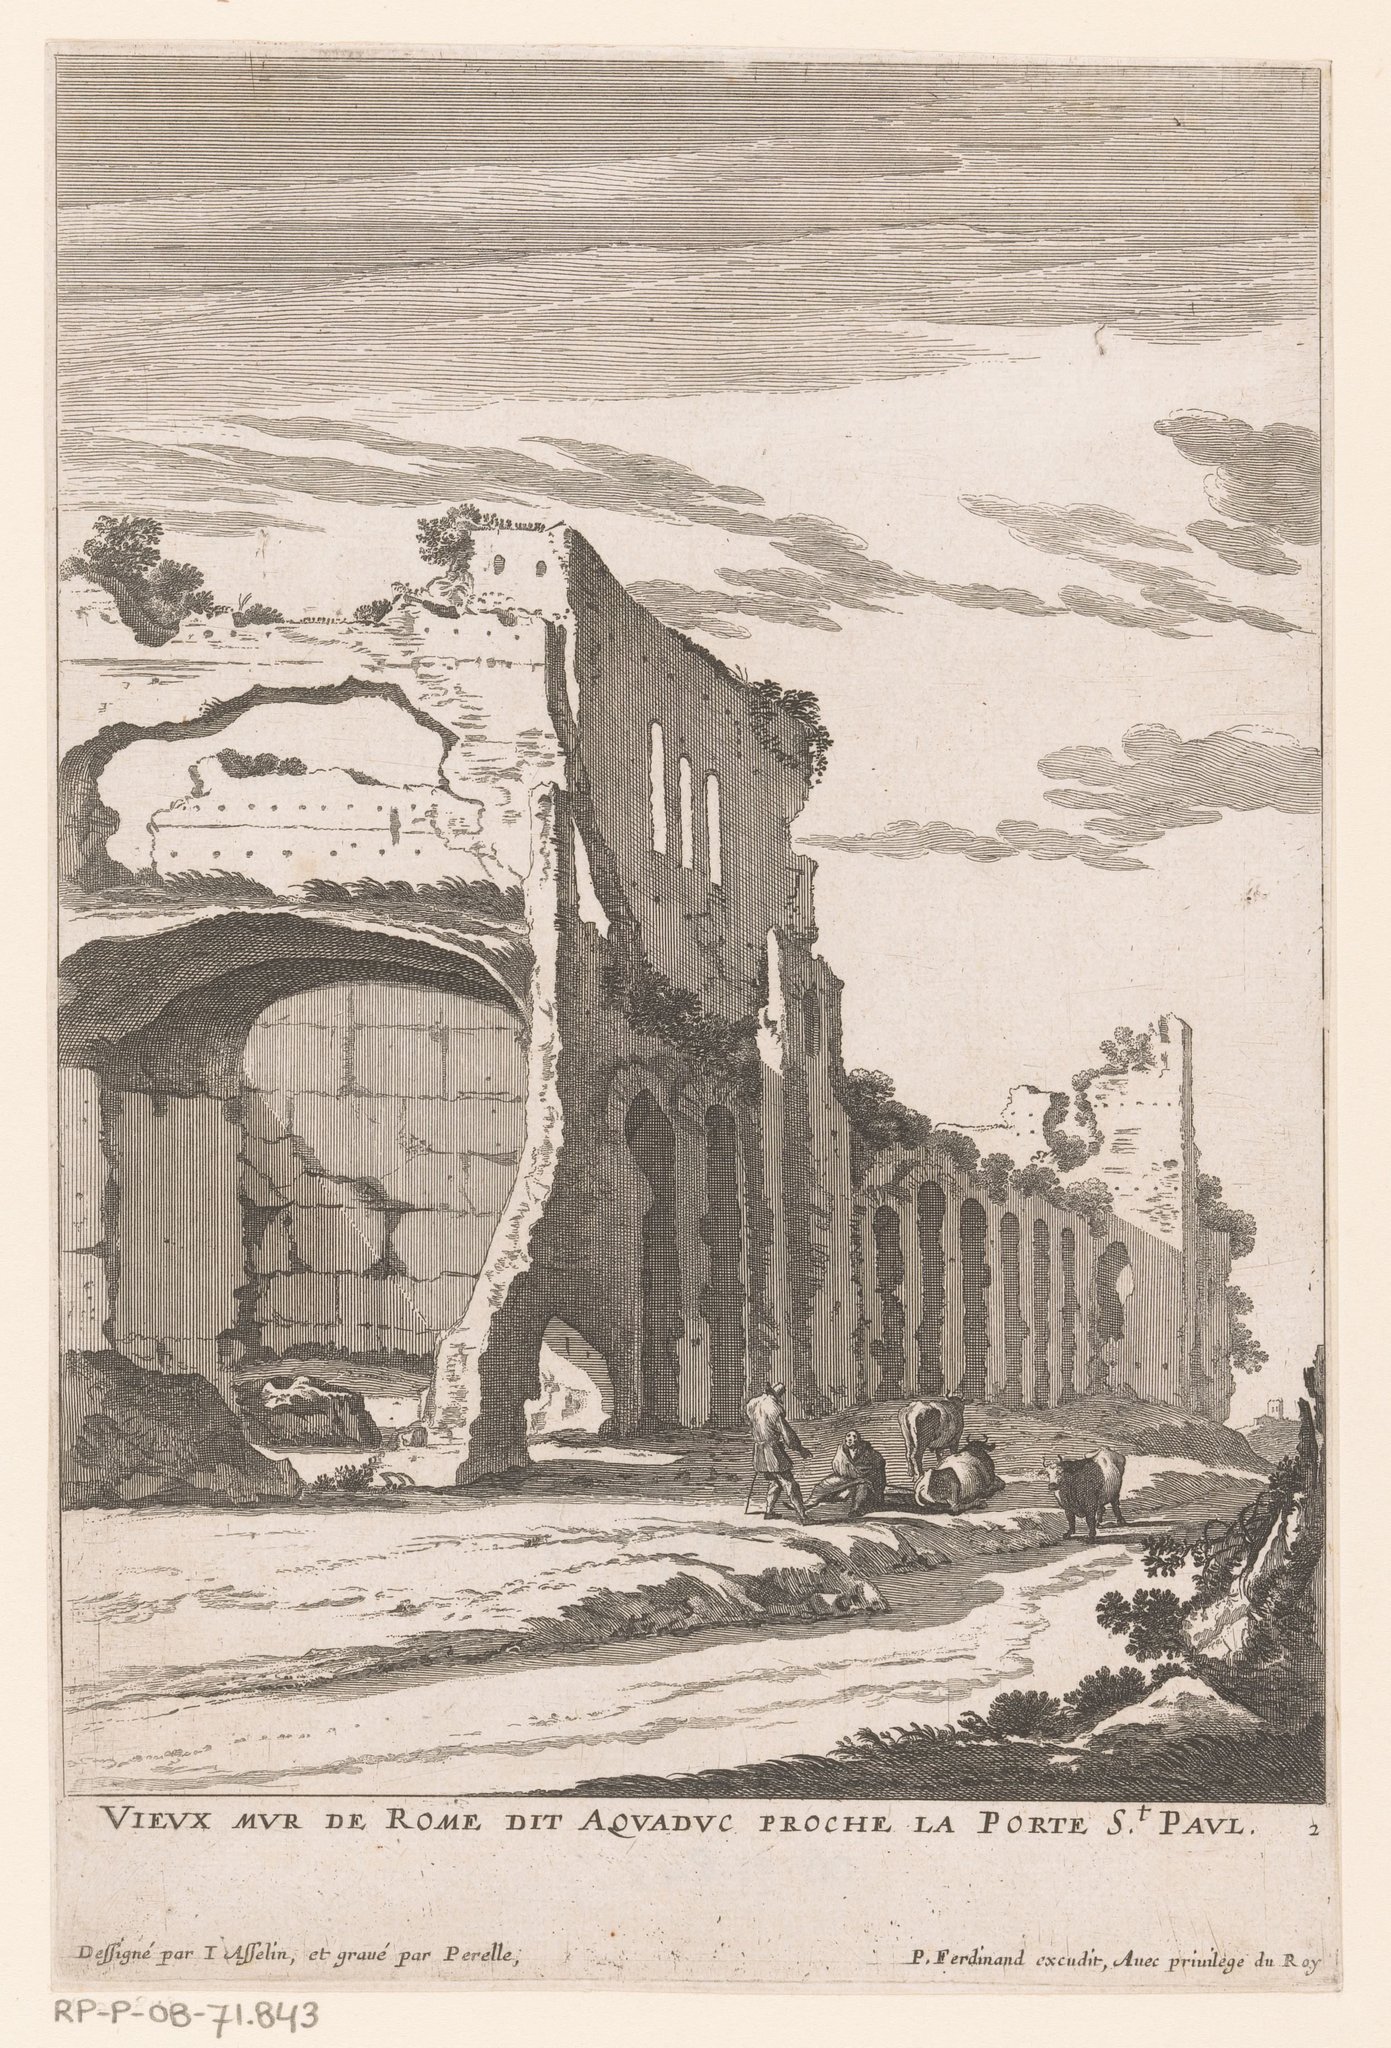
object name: print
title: Vieux Mur de Rome dit Aquaduc proche la Porte St. Paul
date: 1627-1655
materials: paper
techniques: engraving, etching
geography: france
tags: landscape with ruins, rome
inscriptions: collector's mark: Lugt 240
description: Prenten met het signatuur 'Perelle' kunnen zowel door vader Gabriel als door zonen Nicolas en Adam gemaakt zijn.